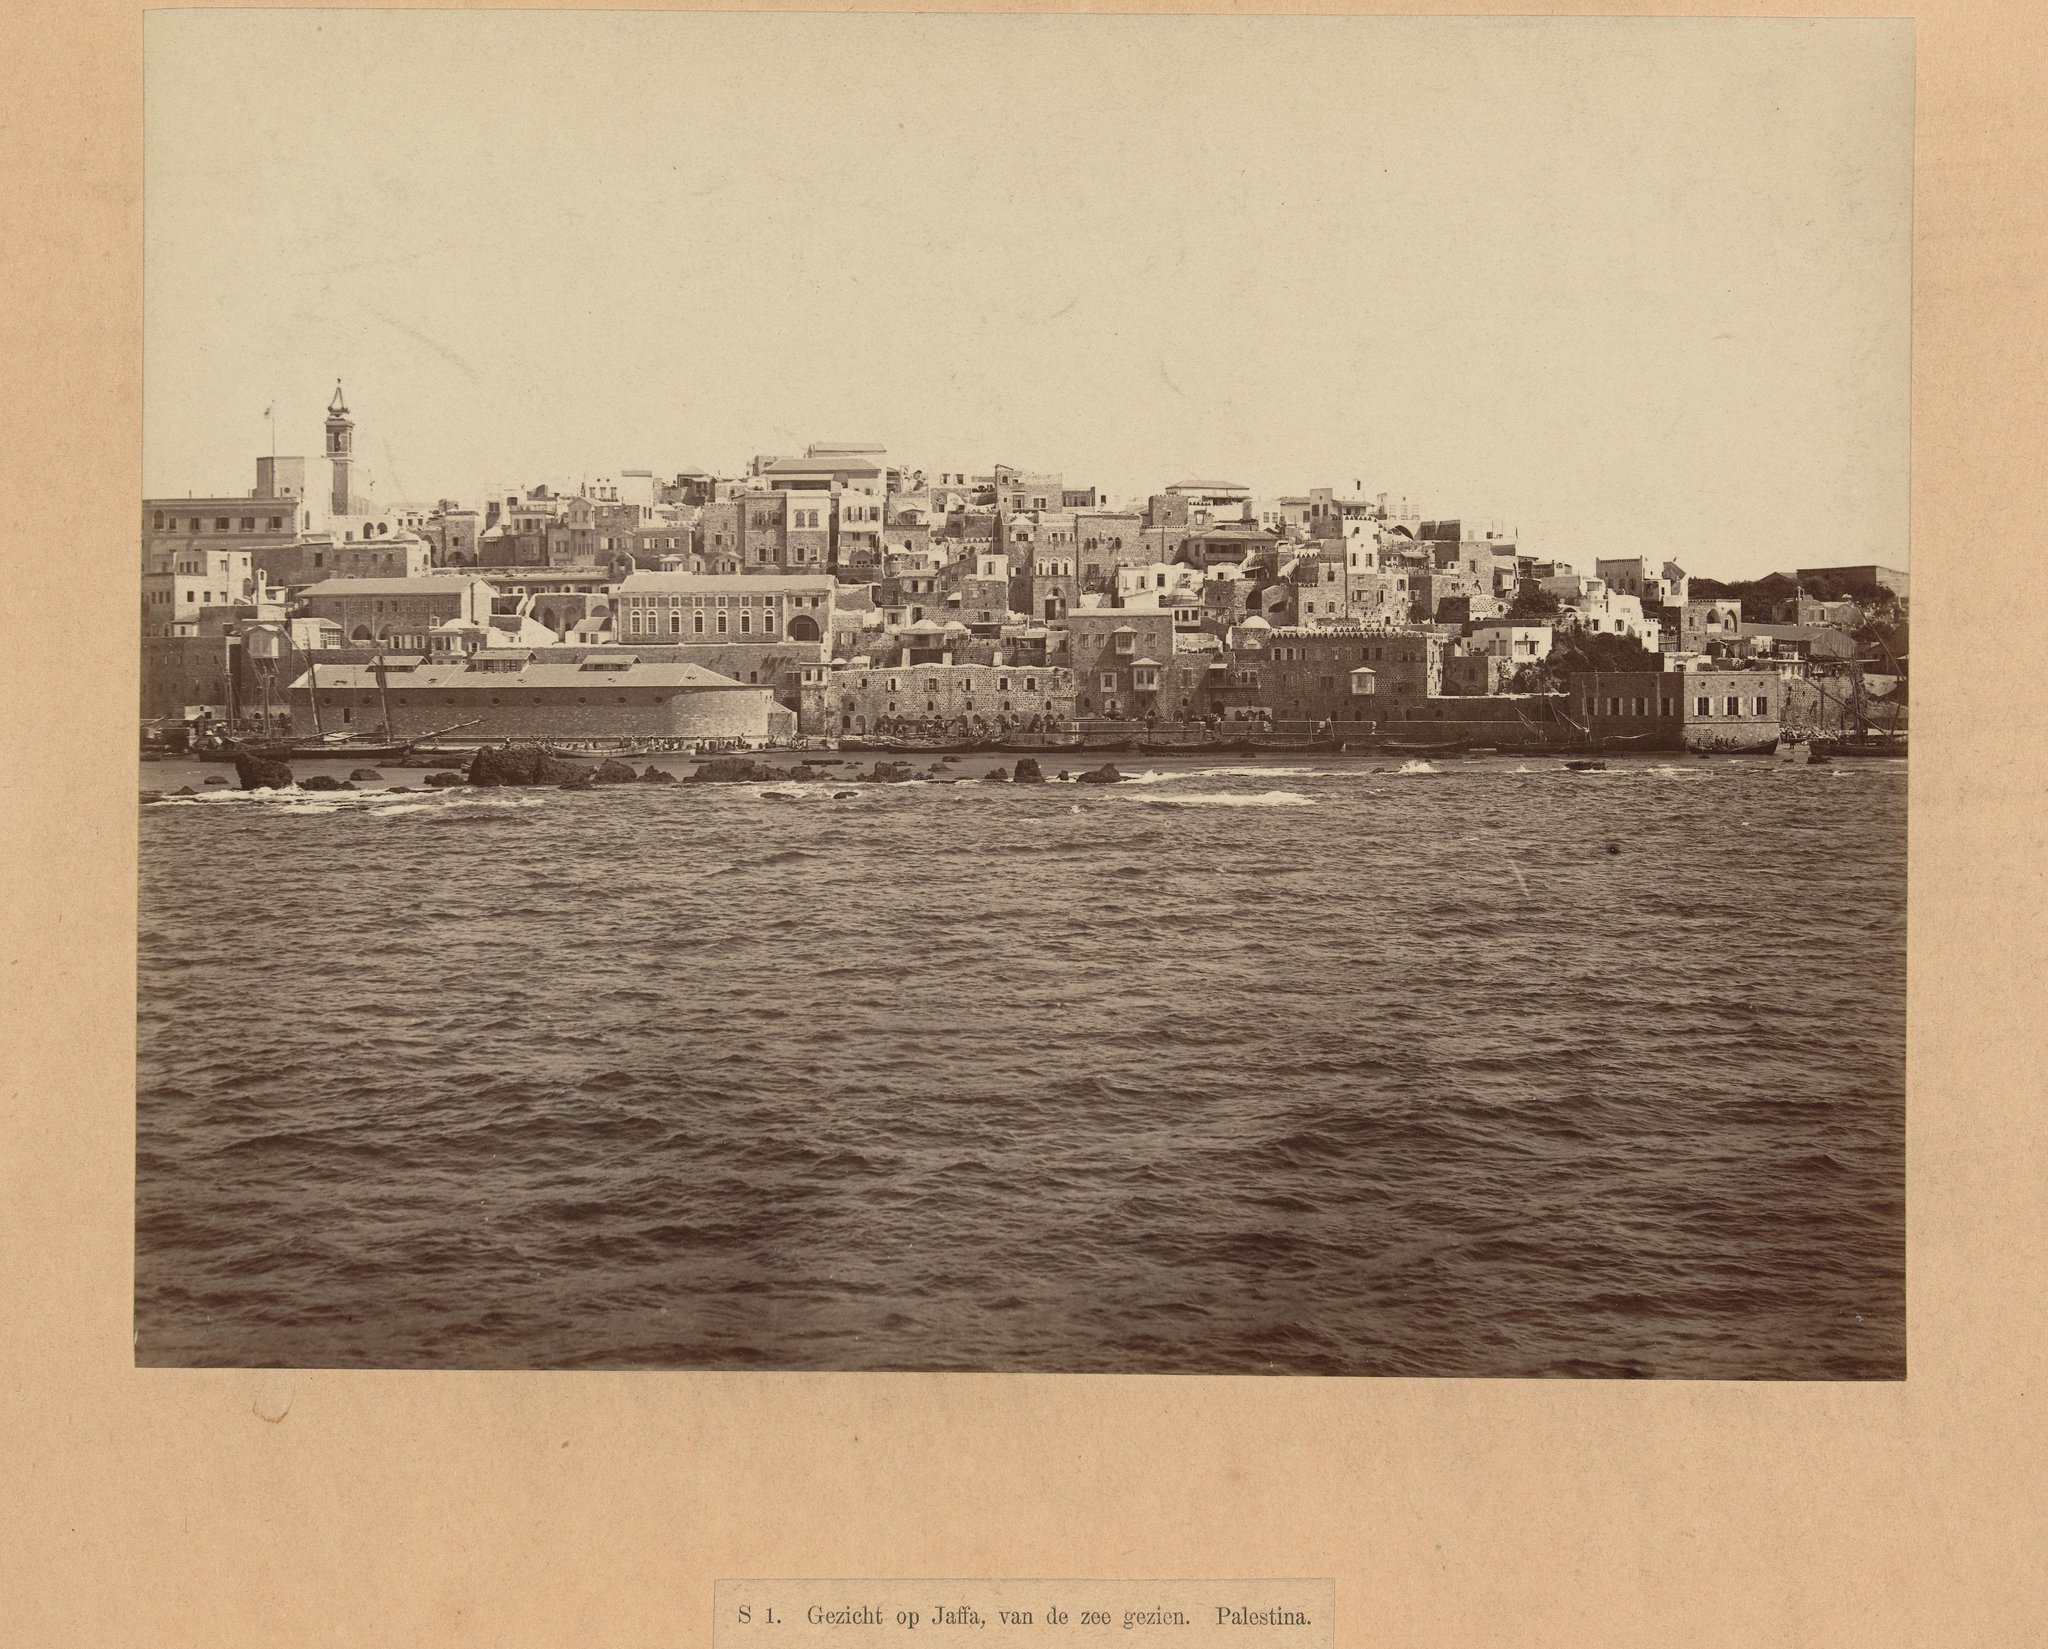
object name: photograph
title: Groep van 55 foto's van Israël, Palestina en Syrië verzameld door Richard Polak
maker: richard polak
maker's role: fotograaf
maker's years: 1870-1957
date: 1867-1895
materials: cardboard, paper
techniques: albumen print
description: Groep van 55 foto's van de provincie Syrië in het Ottomaanse Rijk verzameld door fotograaf Richard Polak. Deze foto's zijn samen met andere op zijn reizen verzamelde foto's tentoongesteld bij de Rotterdamsche Kunstkring (1895), Arti en Amicitiae te Amsterdam (1897-1898?) en Societeit 't Collegie te Kampen (datum vooralsnog onbekend).